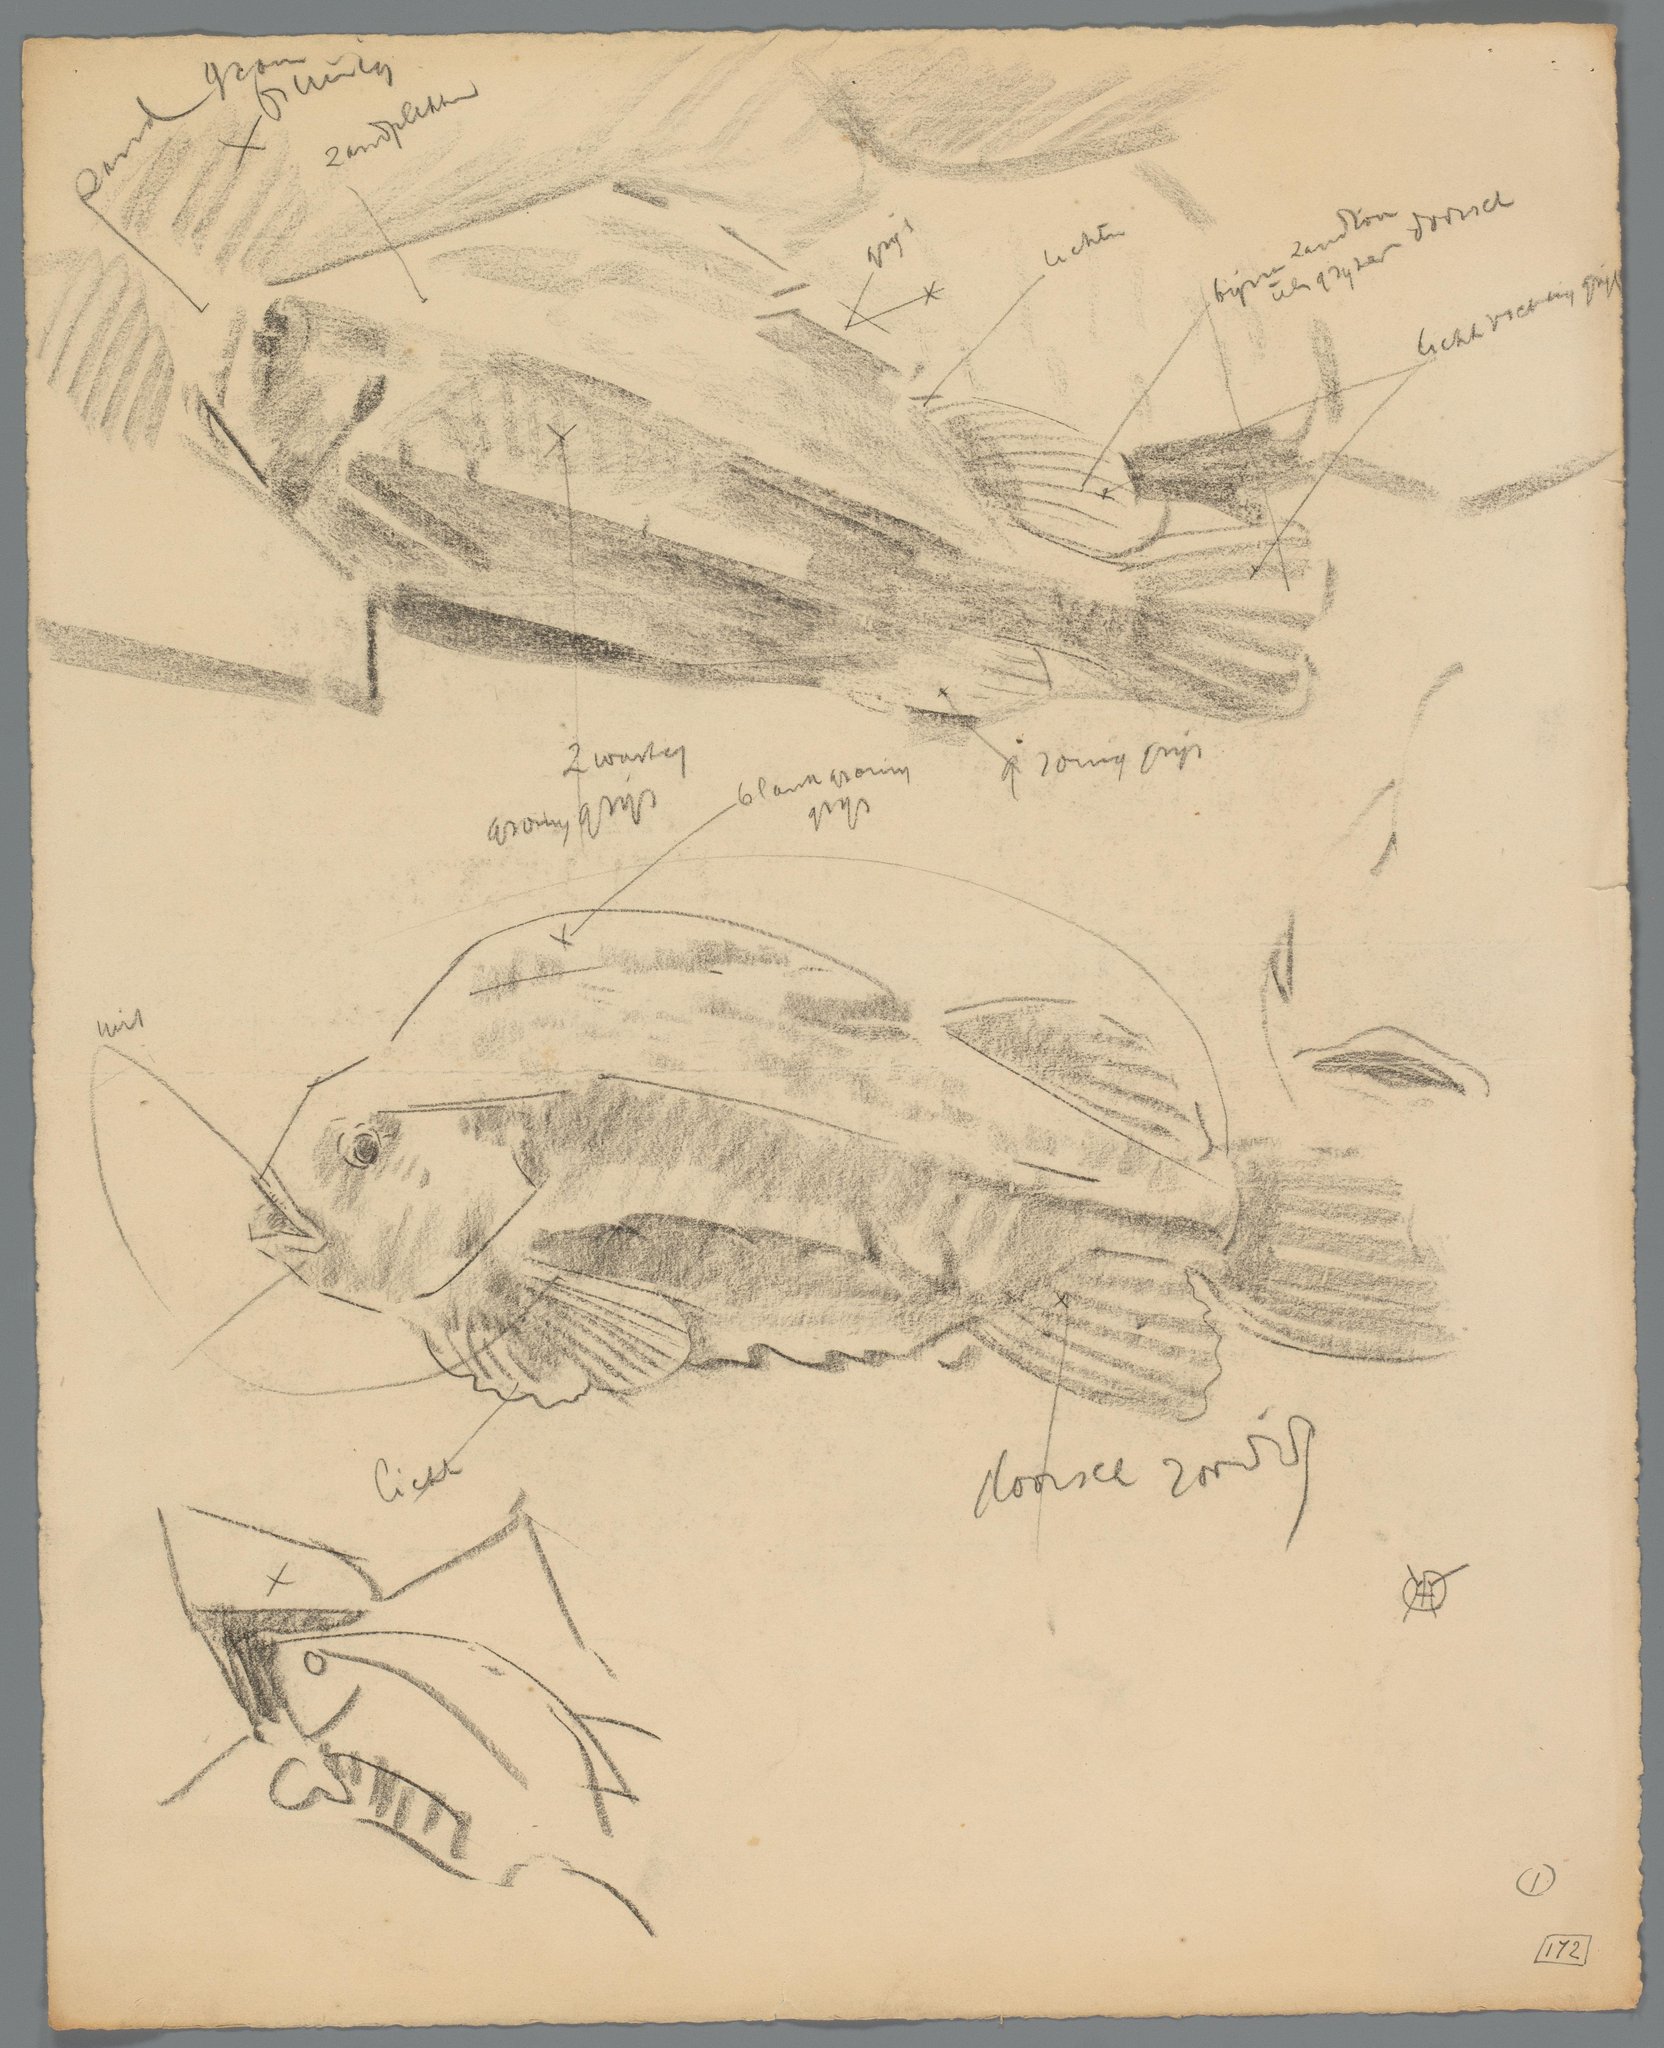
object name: drawing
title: Studies van vissen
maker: gerrit willem dijsselhof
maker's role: designer, draughtsman, print maker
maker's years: 1866-1924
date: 1876-1924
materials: chalk, paper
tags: fishes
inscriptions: number: ‘172’, number: ‘1’